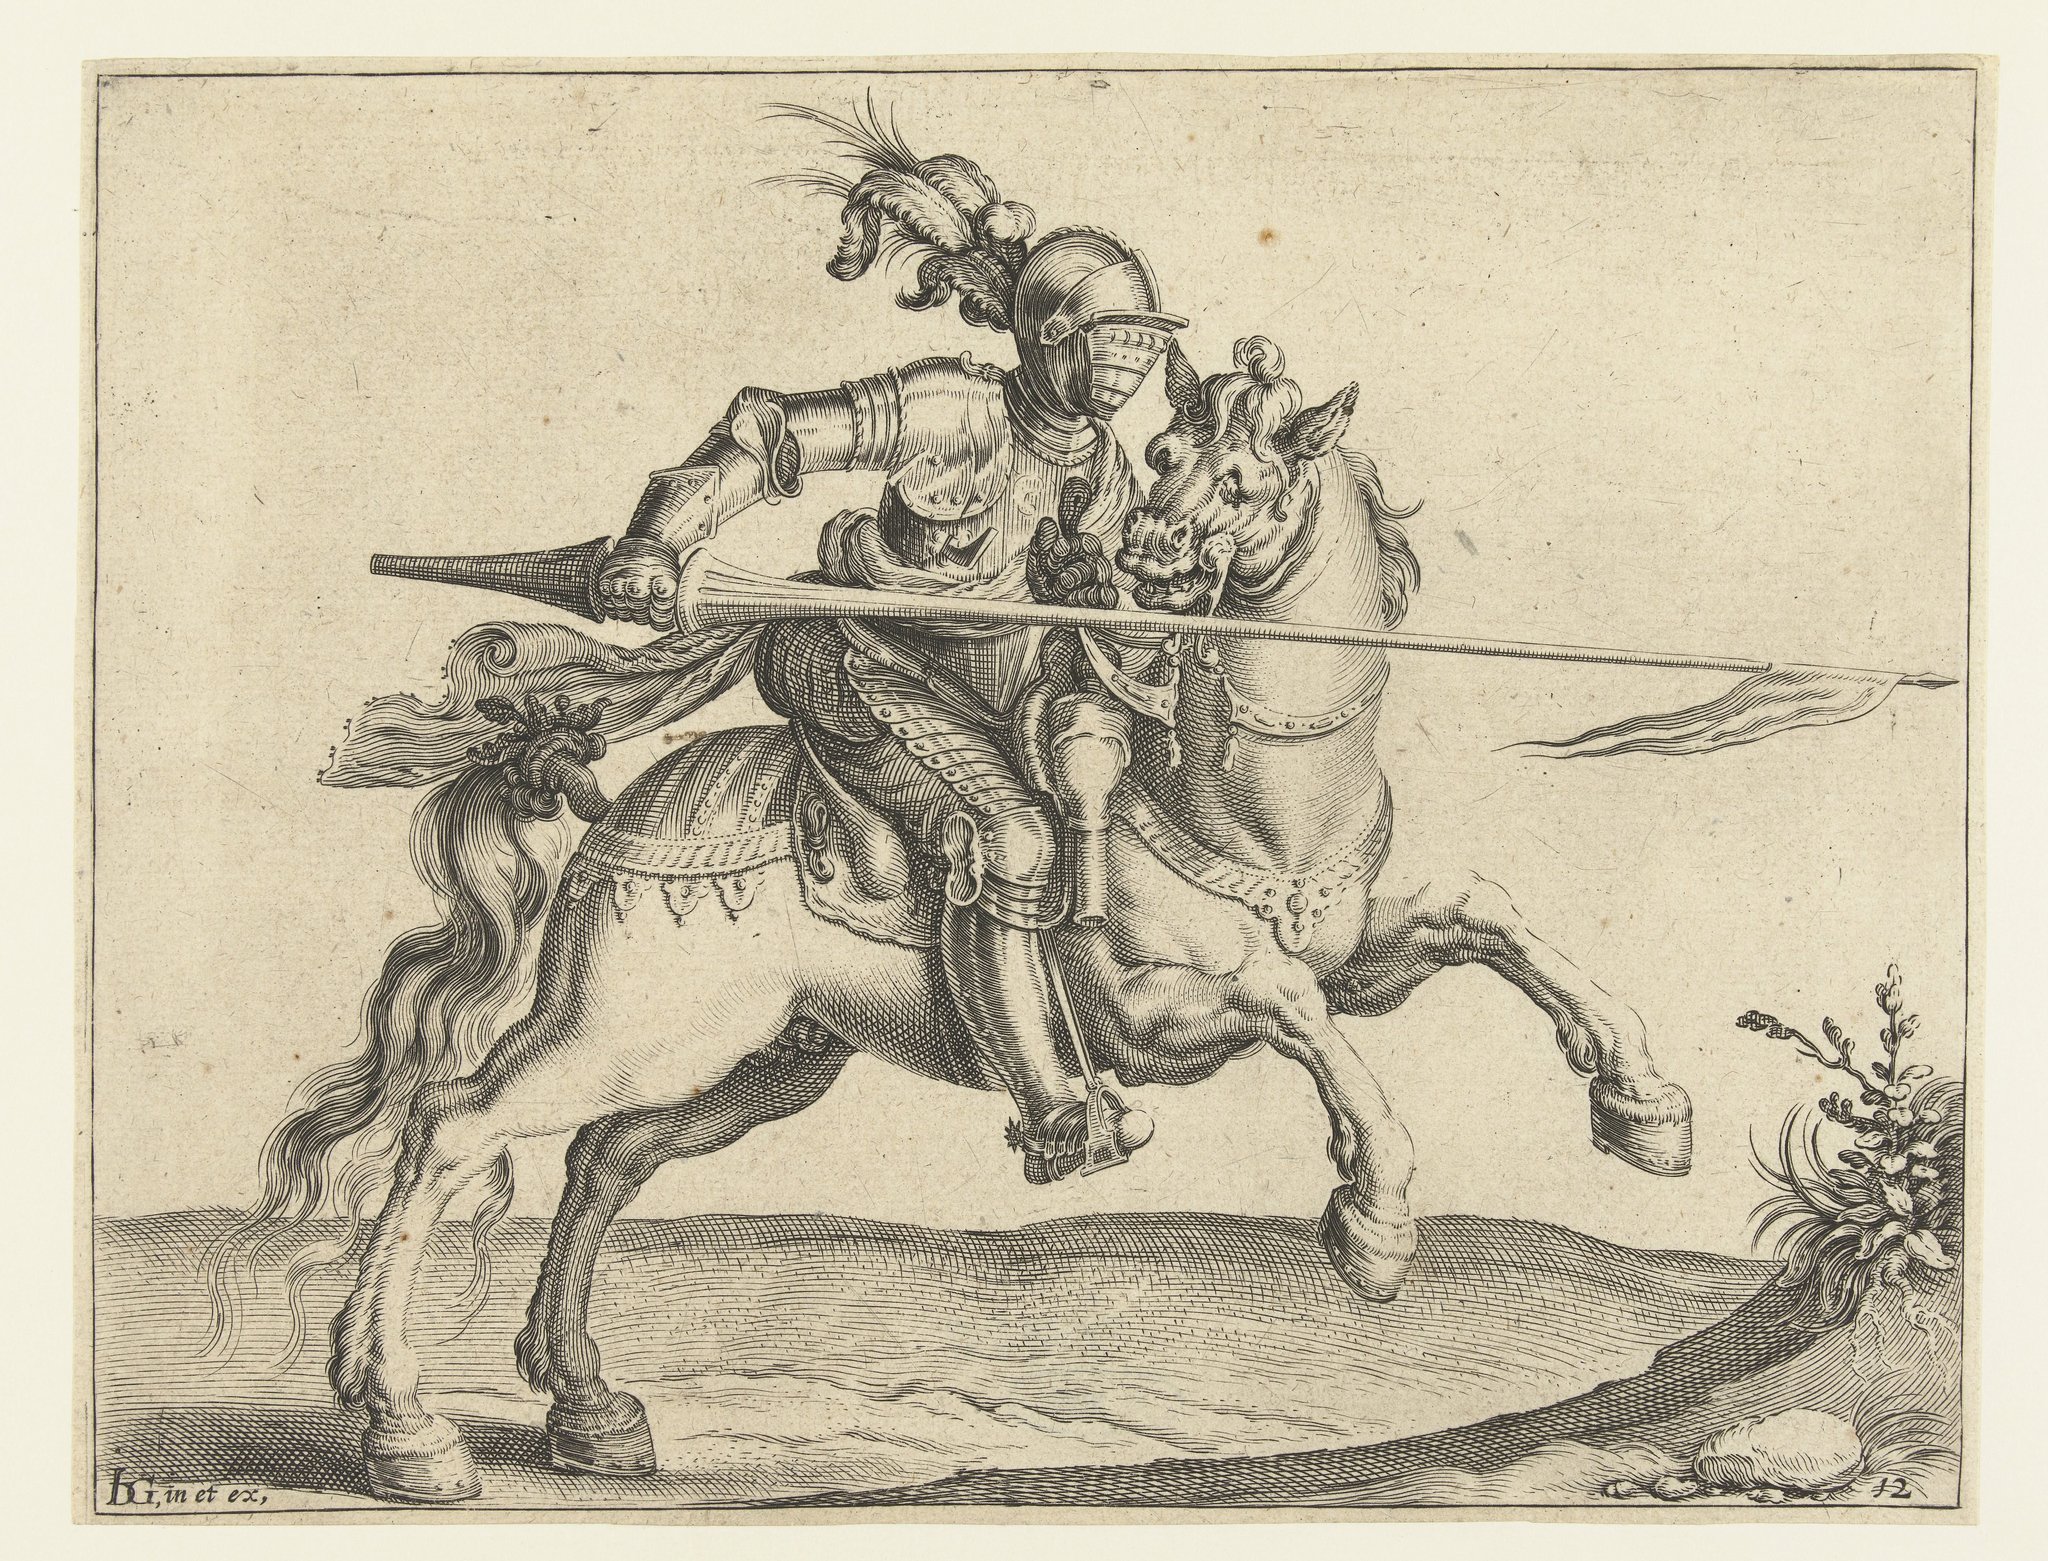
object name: print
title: De ruiterschool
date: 1599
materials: paper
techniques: engraving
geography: netherlands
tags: helved weapons, polearms (for striking, hacking, thrusting): lance, warfare; military affairs (+ cavalry, horsemen)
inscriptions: collector's mark: Lugt 2228a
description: Een geharnaste man te paard (speerruiter) rijdt in aanvallende houding, met vooruitgestoken lans, naar rechts. Deze prent is onderdeel van een serie van 22 genummerde prenten: een titelprent, 20 prenten waarop één of enkele verschillende typen (meest geharnaste) ruiters zijn weergegeven, en een prent met een ruitergevecht.